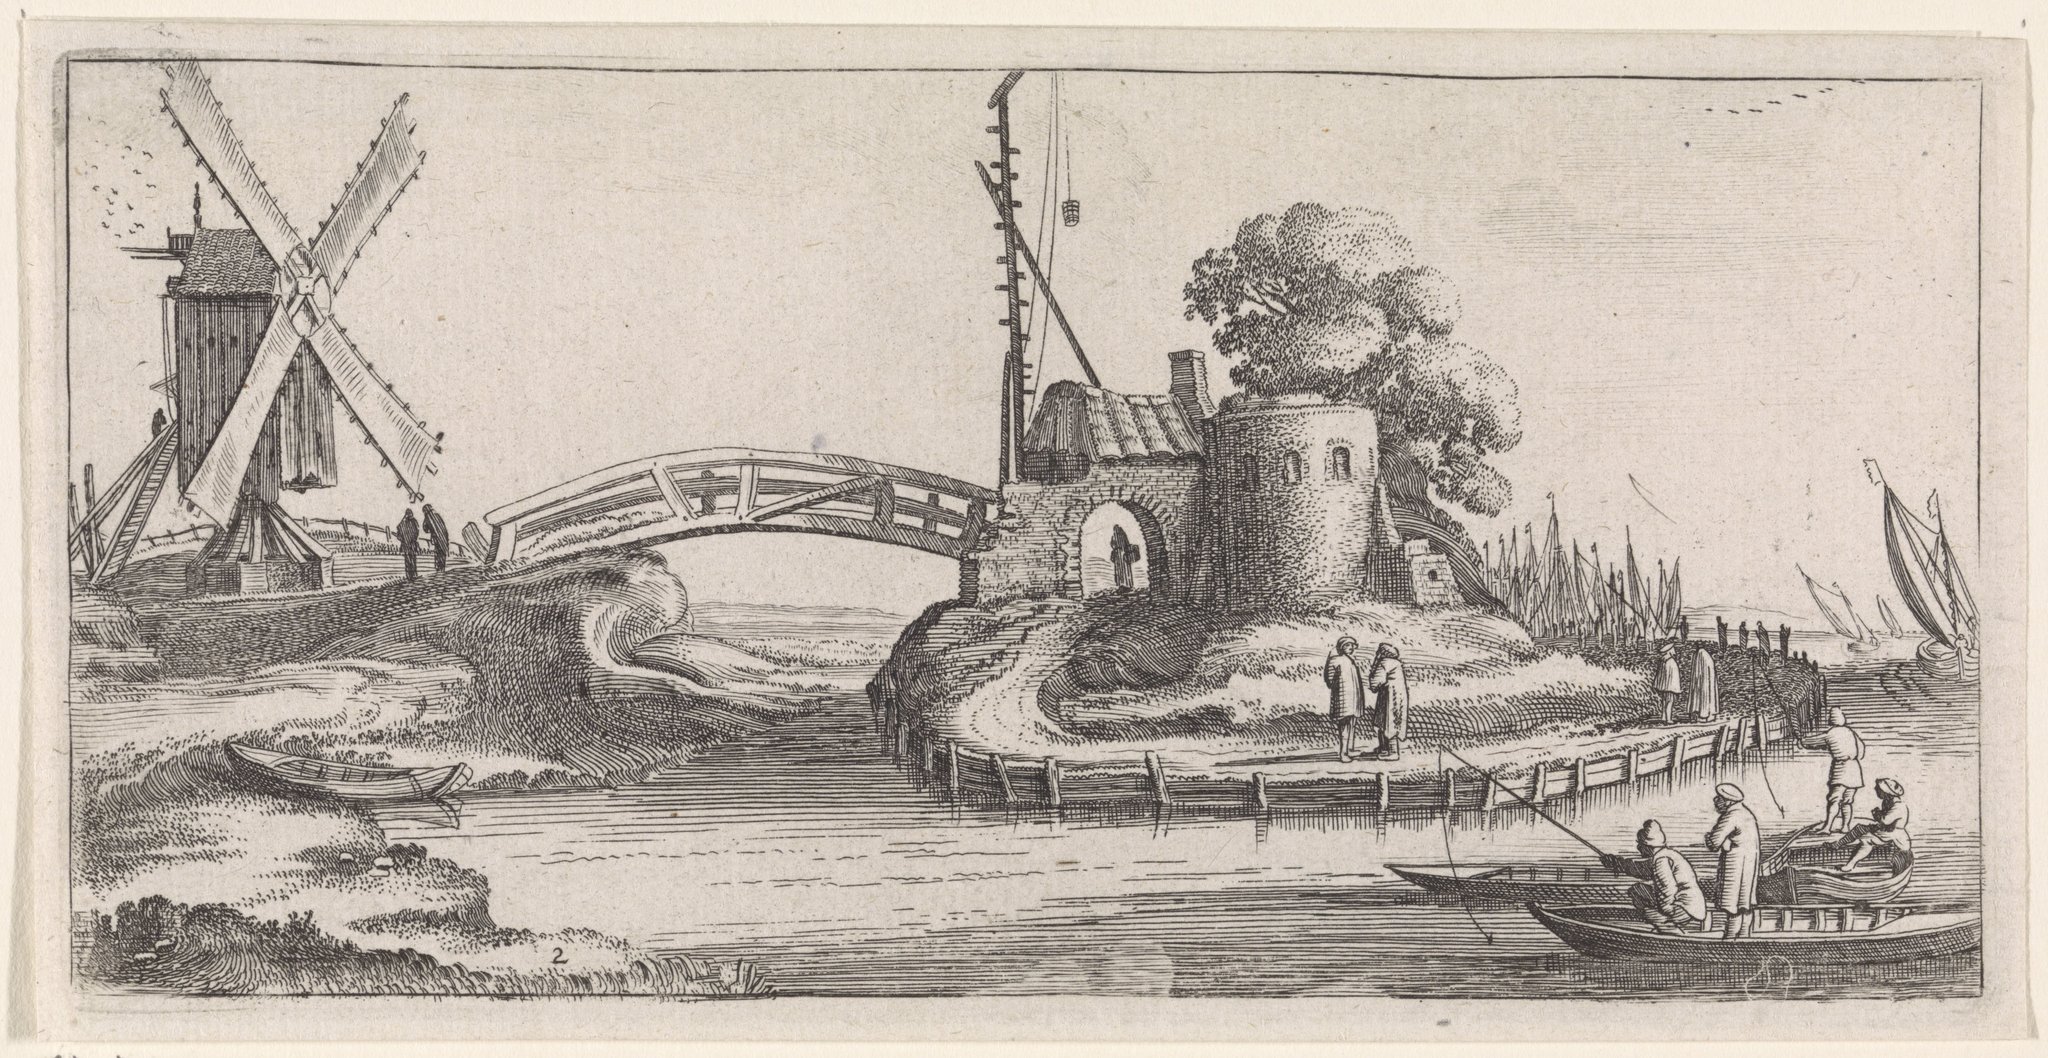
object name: print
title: Figuren in landschappen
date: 1627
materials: paper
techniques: engraving, etching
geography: northern netherlands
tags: island, landscape with bridge, viaduct or aqueduct, gate, entrance, windmill in landscape, beacon, angling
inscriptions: collector's mark: Lugt 240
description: Rivierlandschap met hengelaars in boten. Links op de oever twee figuren bij een molen. Een houten brug verbindt de oever met een riviereiland waarop een poortgebouw met een baken. Linksonder genummerd: 2. De genummerde prenten zijn als serie van tien uitgeven.